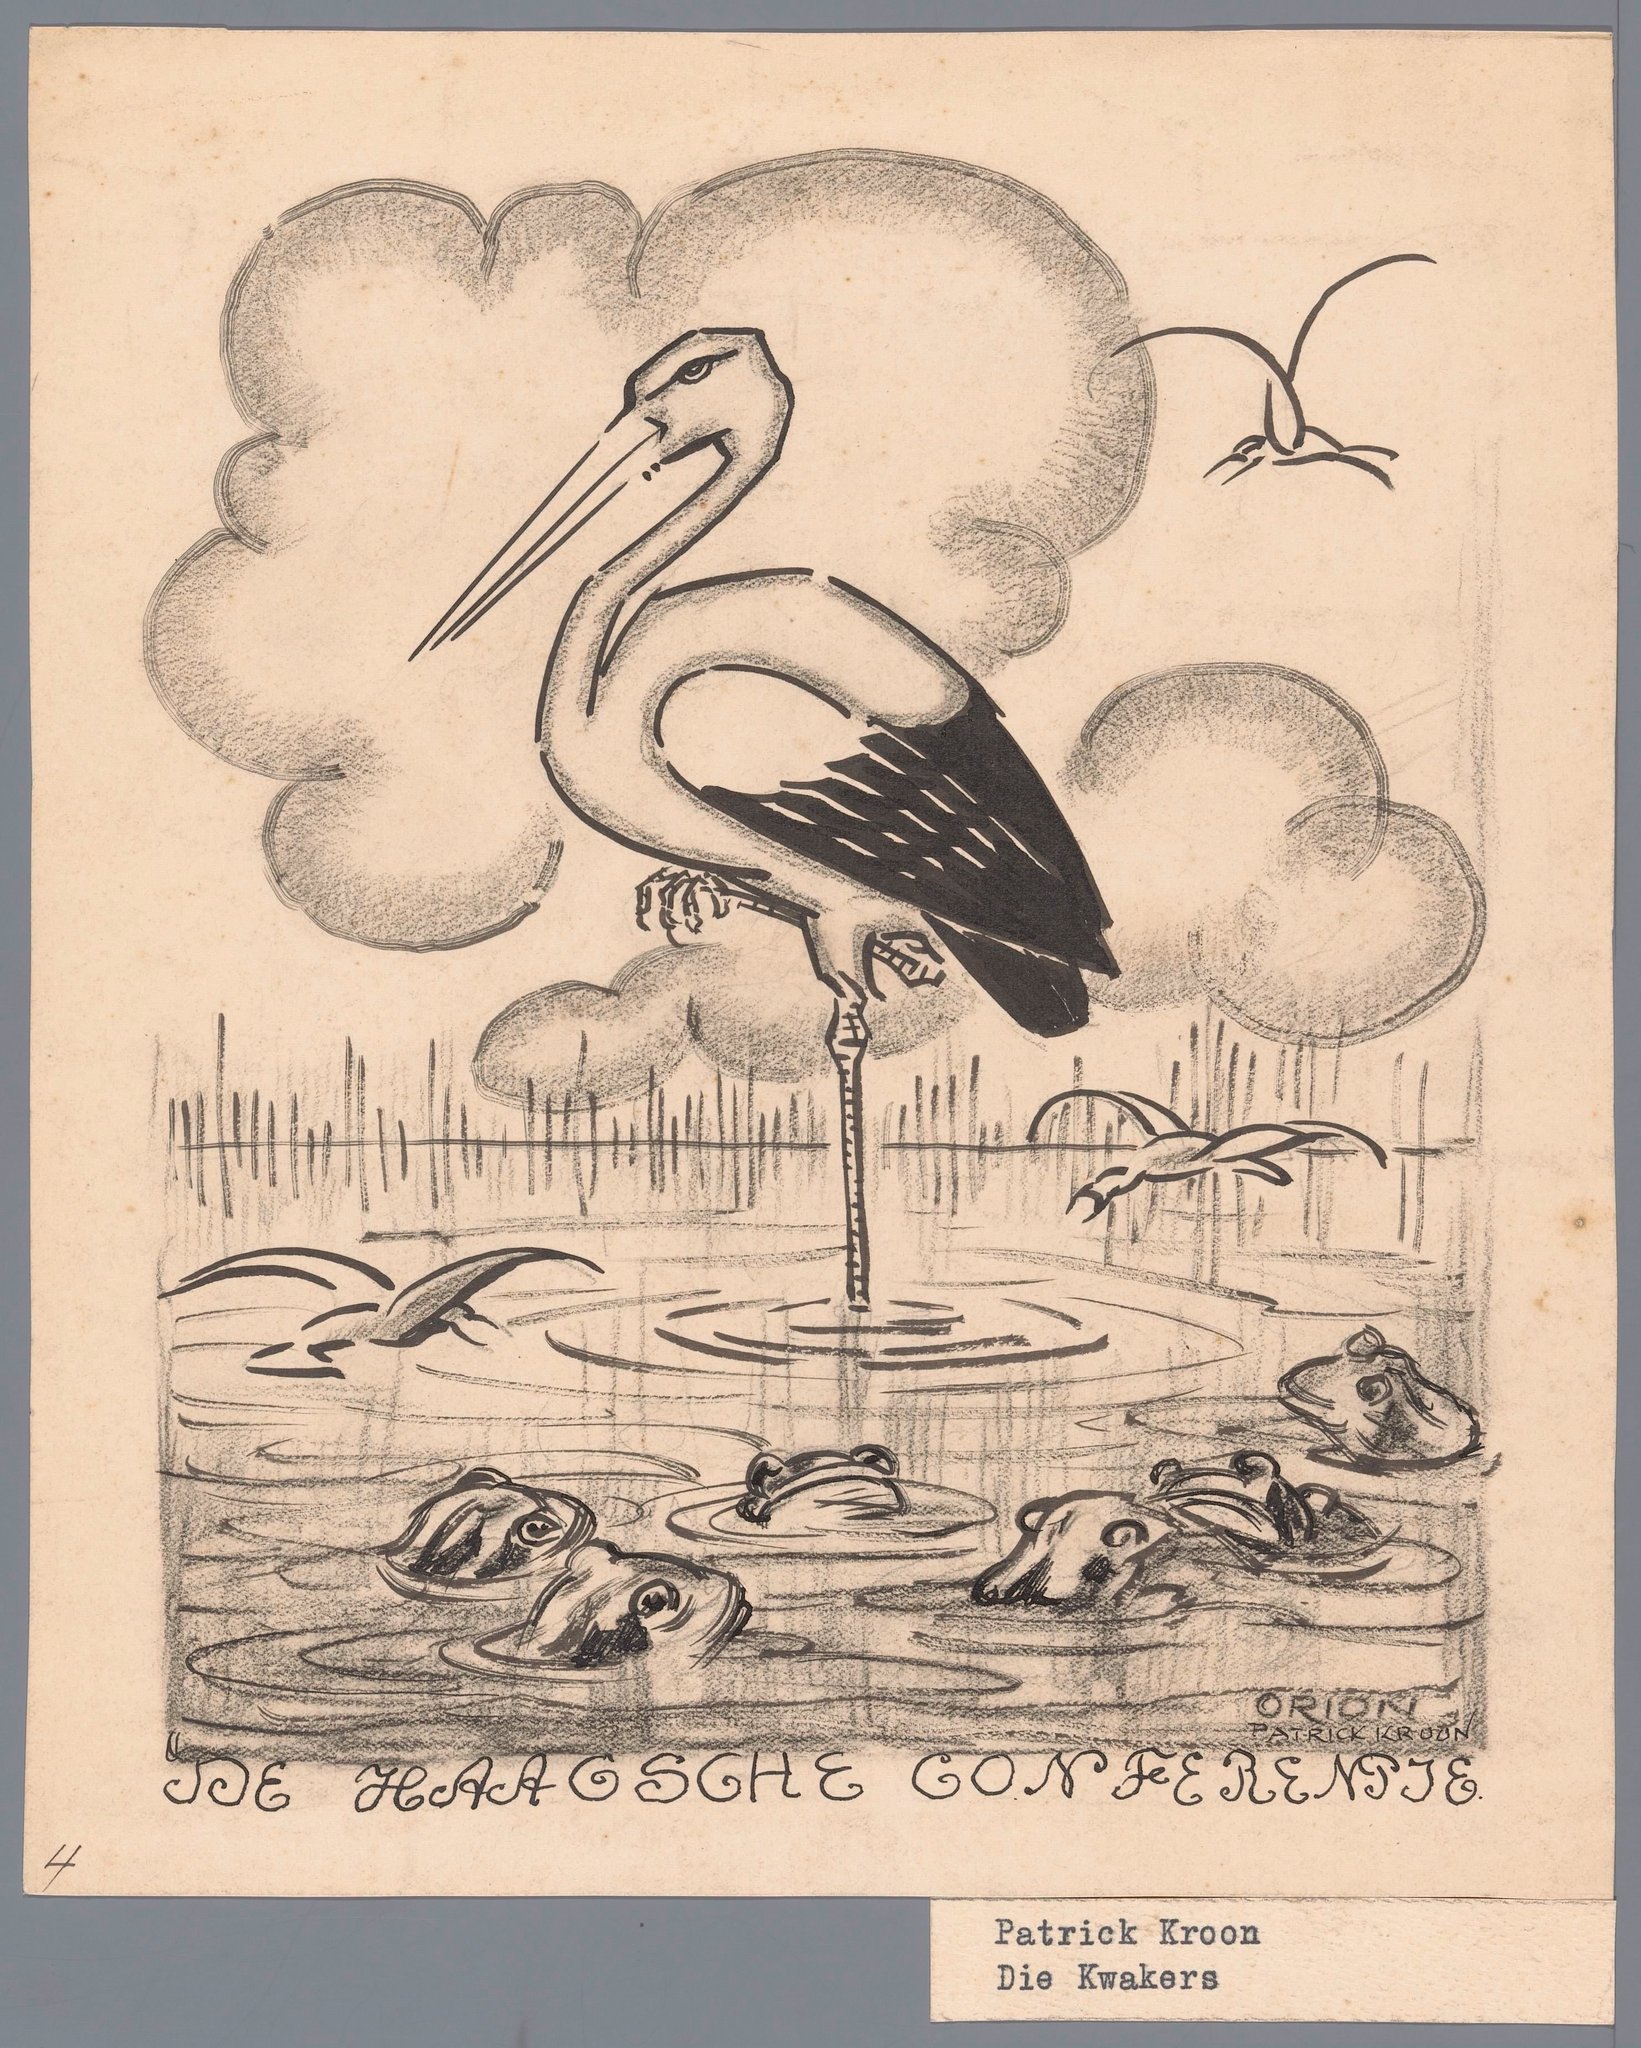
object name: cartoon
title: De Haagsche Conferentie / De Kwakers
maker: patricq kroon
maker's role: draughtsman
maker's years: 1862-1941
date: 1900-1935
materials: chalk, ink, paper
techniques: brush, pen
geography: netherlands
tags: shore-birds and wading-birds: stork, peace negotiations, political caricatures and satires, the hague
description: Een ooievaar staande op één poot in het water tussen kikkers. Naar aanleiding van een conferentie in Den Haag. Ontwerp voor een politieke spotprent.